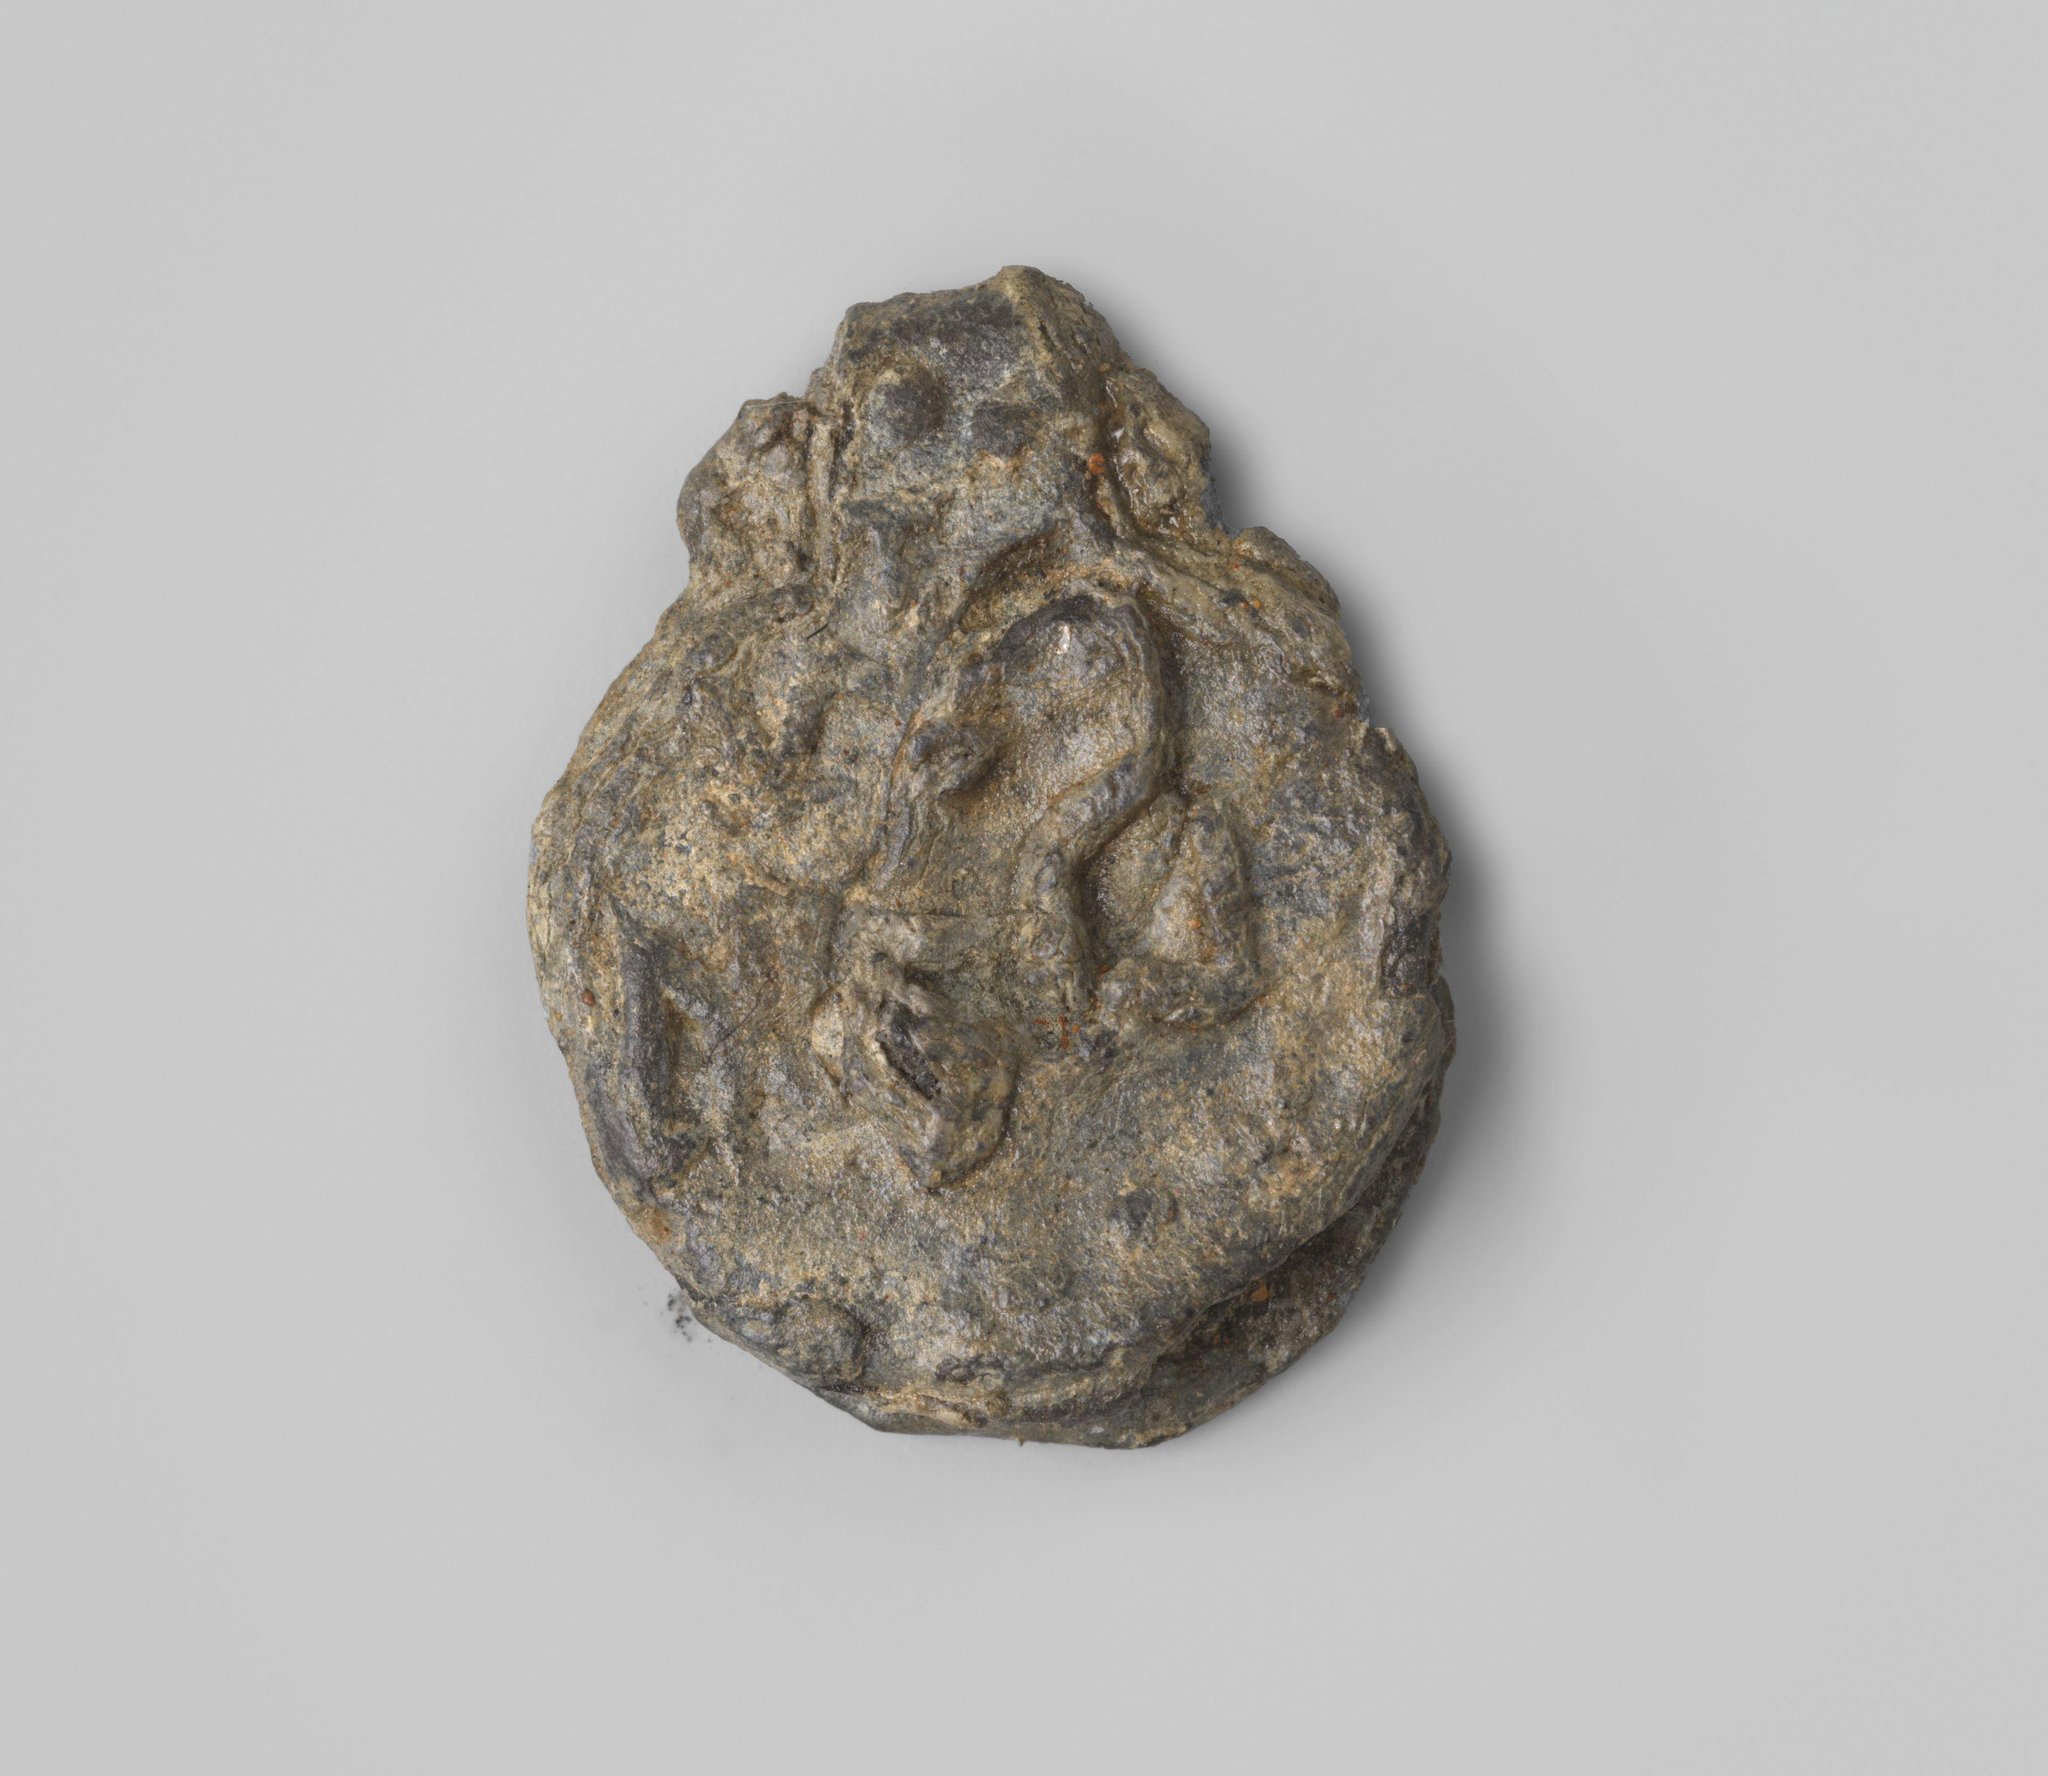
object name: lakenloodje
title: Lakenloodje uit het wrak van de Oost-Indiëvaarder Hollandia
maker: Anonymous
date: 1700-1743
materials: lead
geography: netherlands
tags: verenigde oostindische compagnie, hollandia (schip), annet